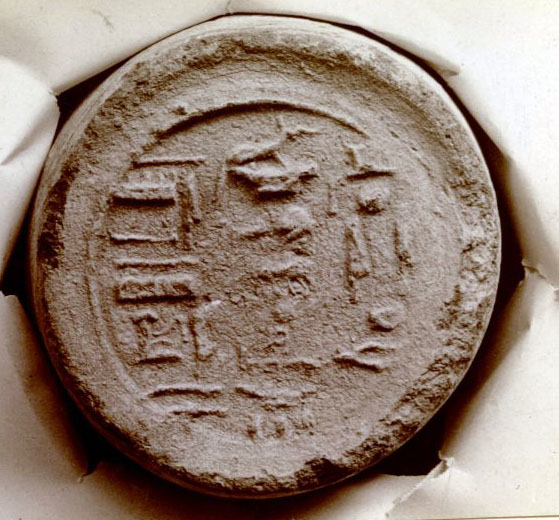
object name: cone, seshi, circular, overseer, ship, amun, anubis, hollow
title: Funerary Cone the Overseer of the Ships Amun Seshi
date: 1550-1295 BCE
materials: pottery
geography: egypt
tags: hieroglyphs